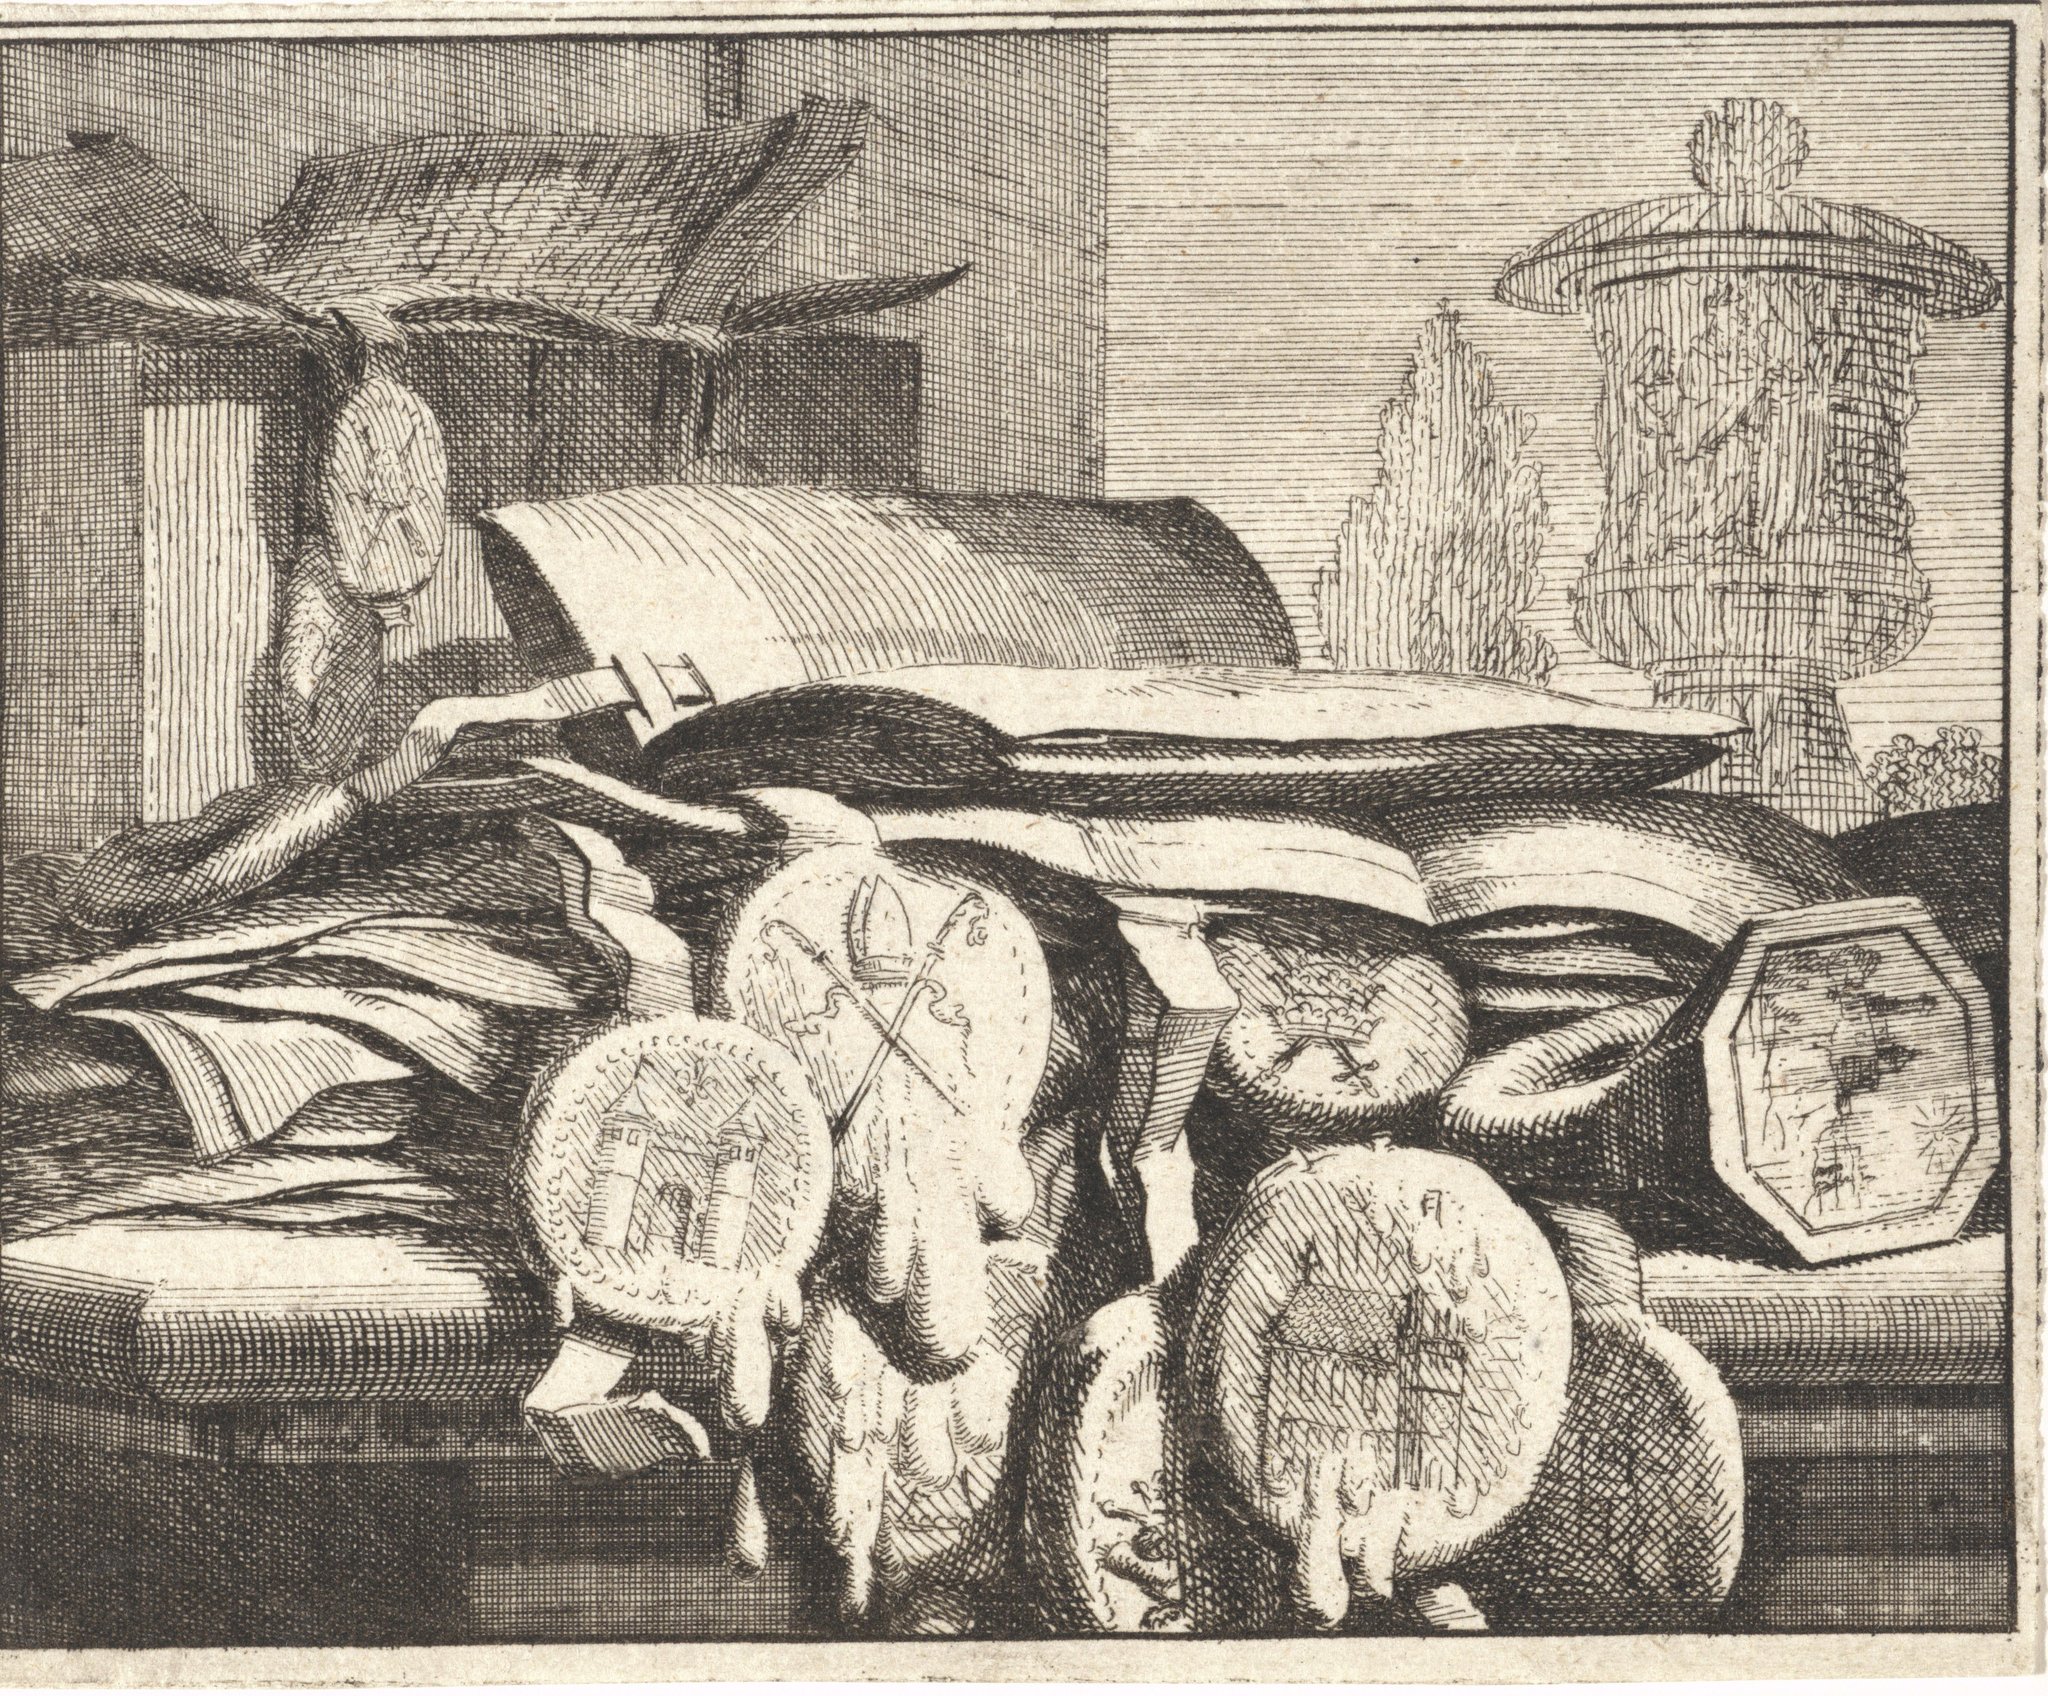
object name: print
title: Gesmolten zegels en een zegelring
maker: vincent laurensz. van der vinne (ii)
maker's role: draughtsman, print maker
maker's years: 1686-1742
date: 1714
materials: paper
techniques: etching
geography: haarlem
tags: sealing wax, seal, stamp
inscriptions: collector's mark: Lugt 2228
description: Op een tafel liggen documenten waarvan de zegels smelten. Rechts een zegelring. Zinnebeeld op de mens die als was is en waarin de wereld als een zegelring steeds een nieuw idee kan drukken.